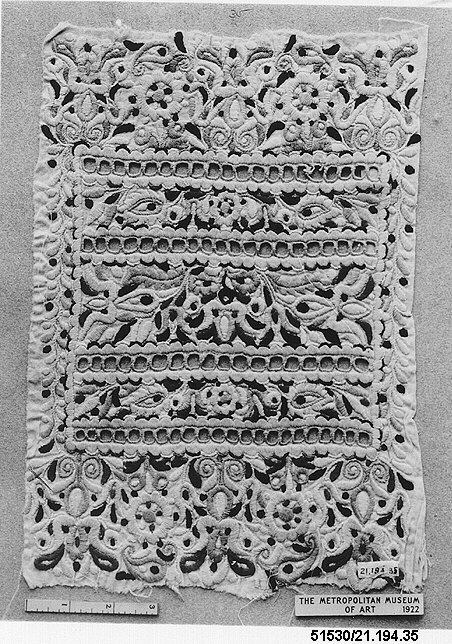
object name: sleeve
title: Sleeve top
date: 1801-1900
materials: cotton, linen